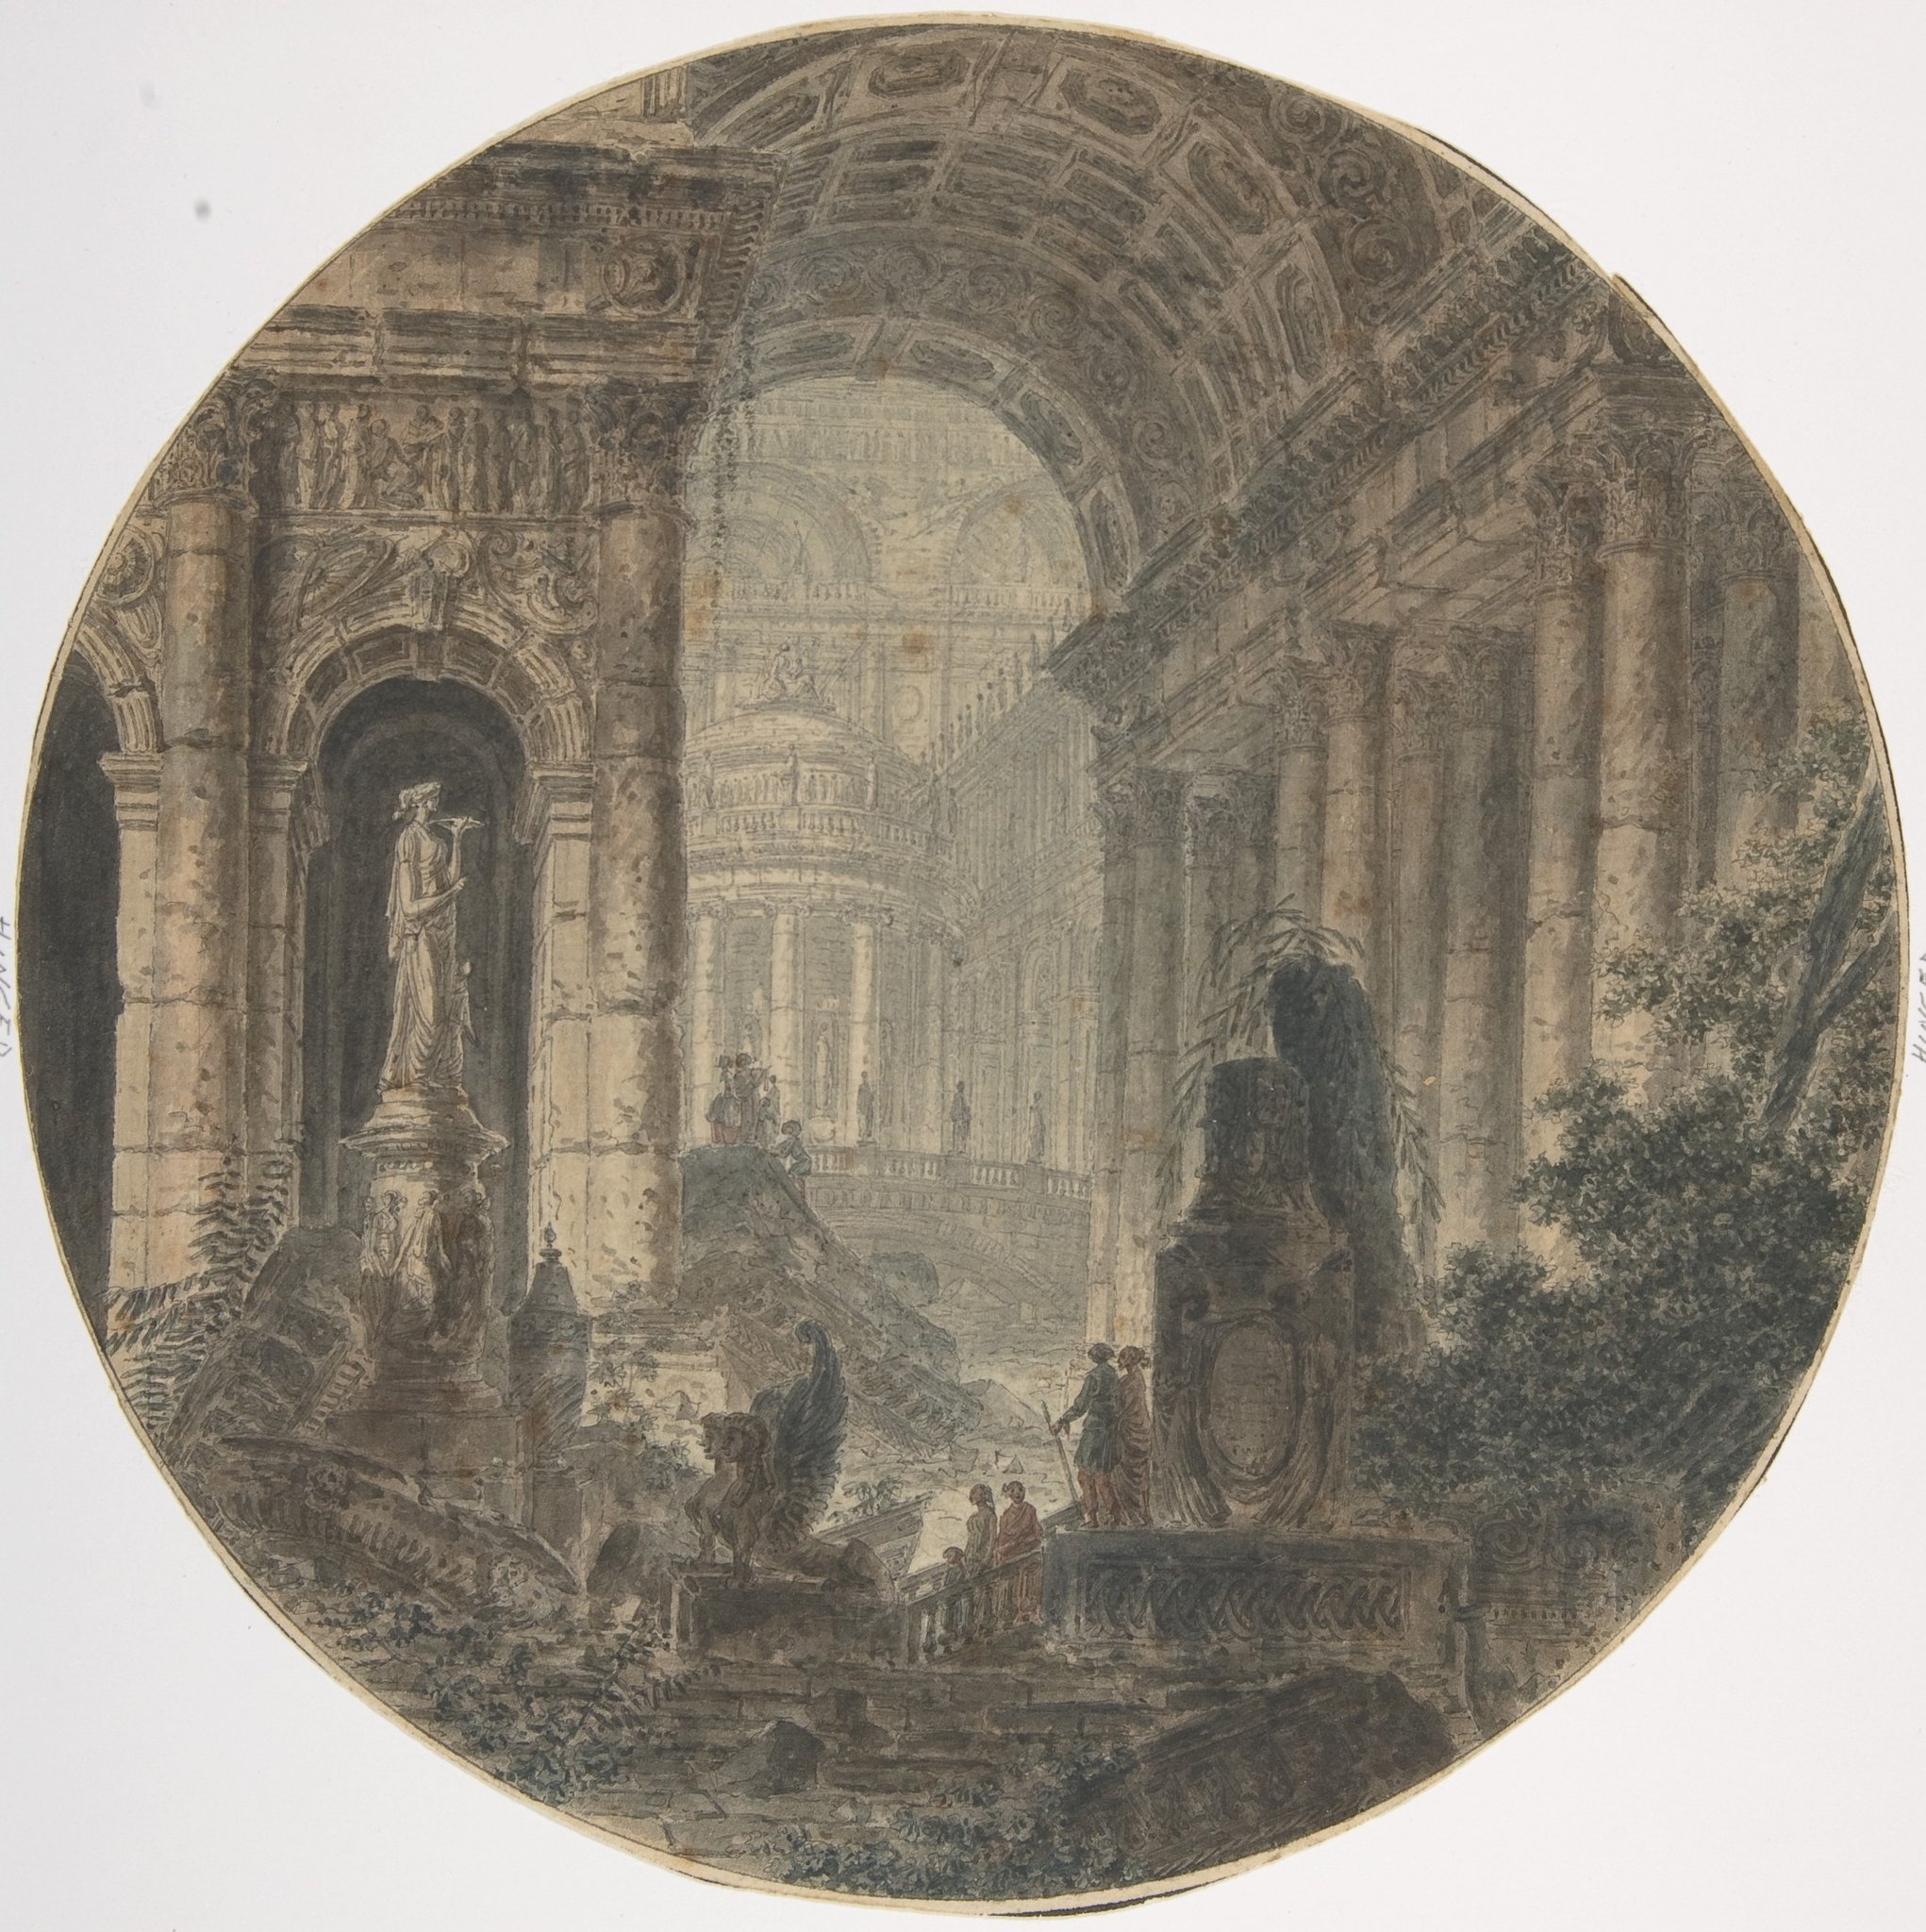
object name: drawing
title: Architectural fantasy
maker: jean henri alexandre pernet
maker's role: artist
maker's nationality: french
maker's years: 1763-1789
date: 1701-1800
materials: ink, watercolor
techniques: pen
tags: architecture